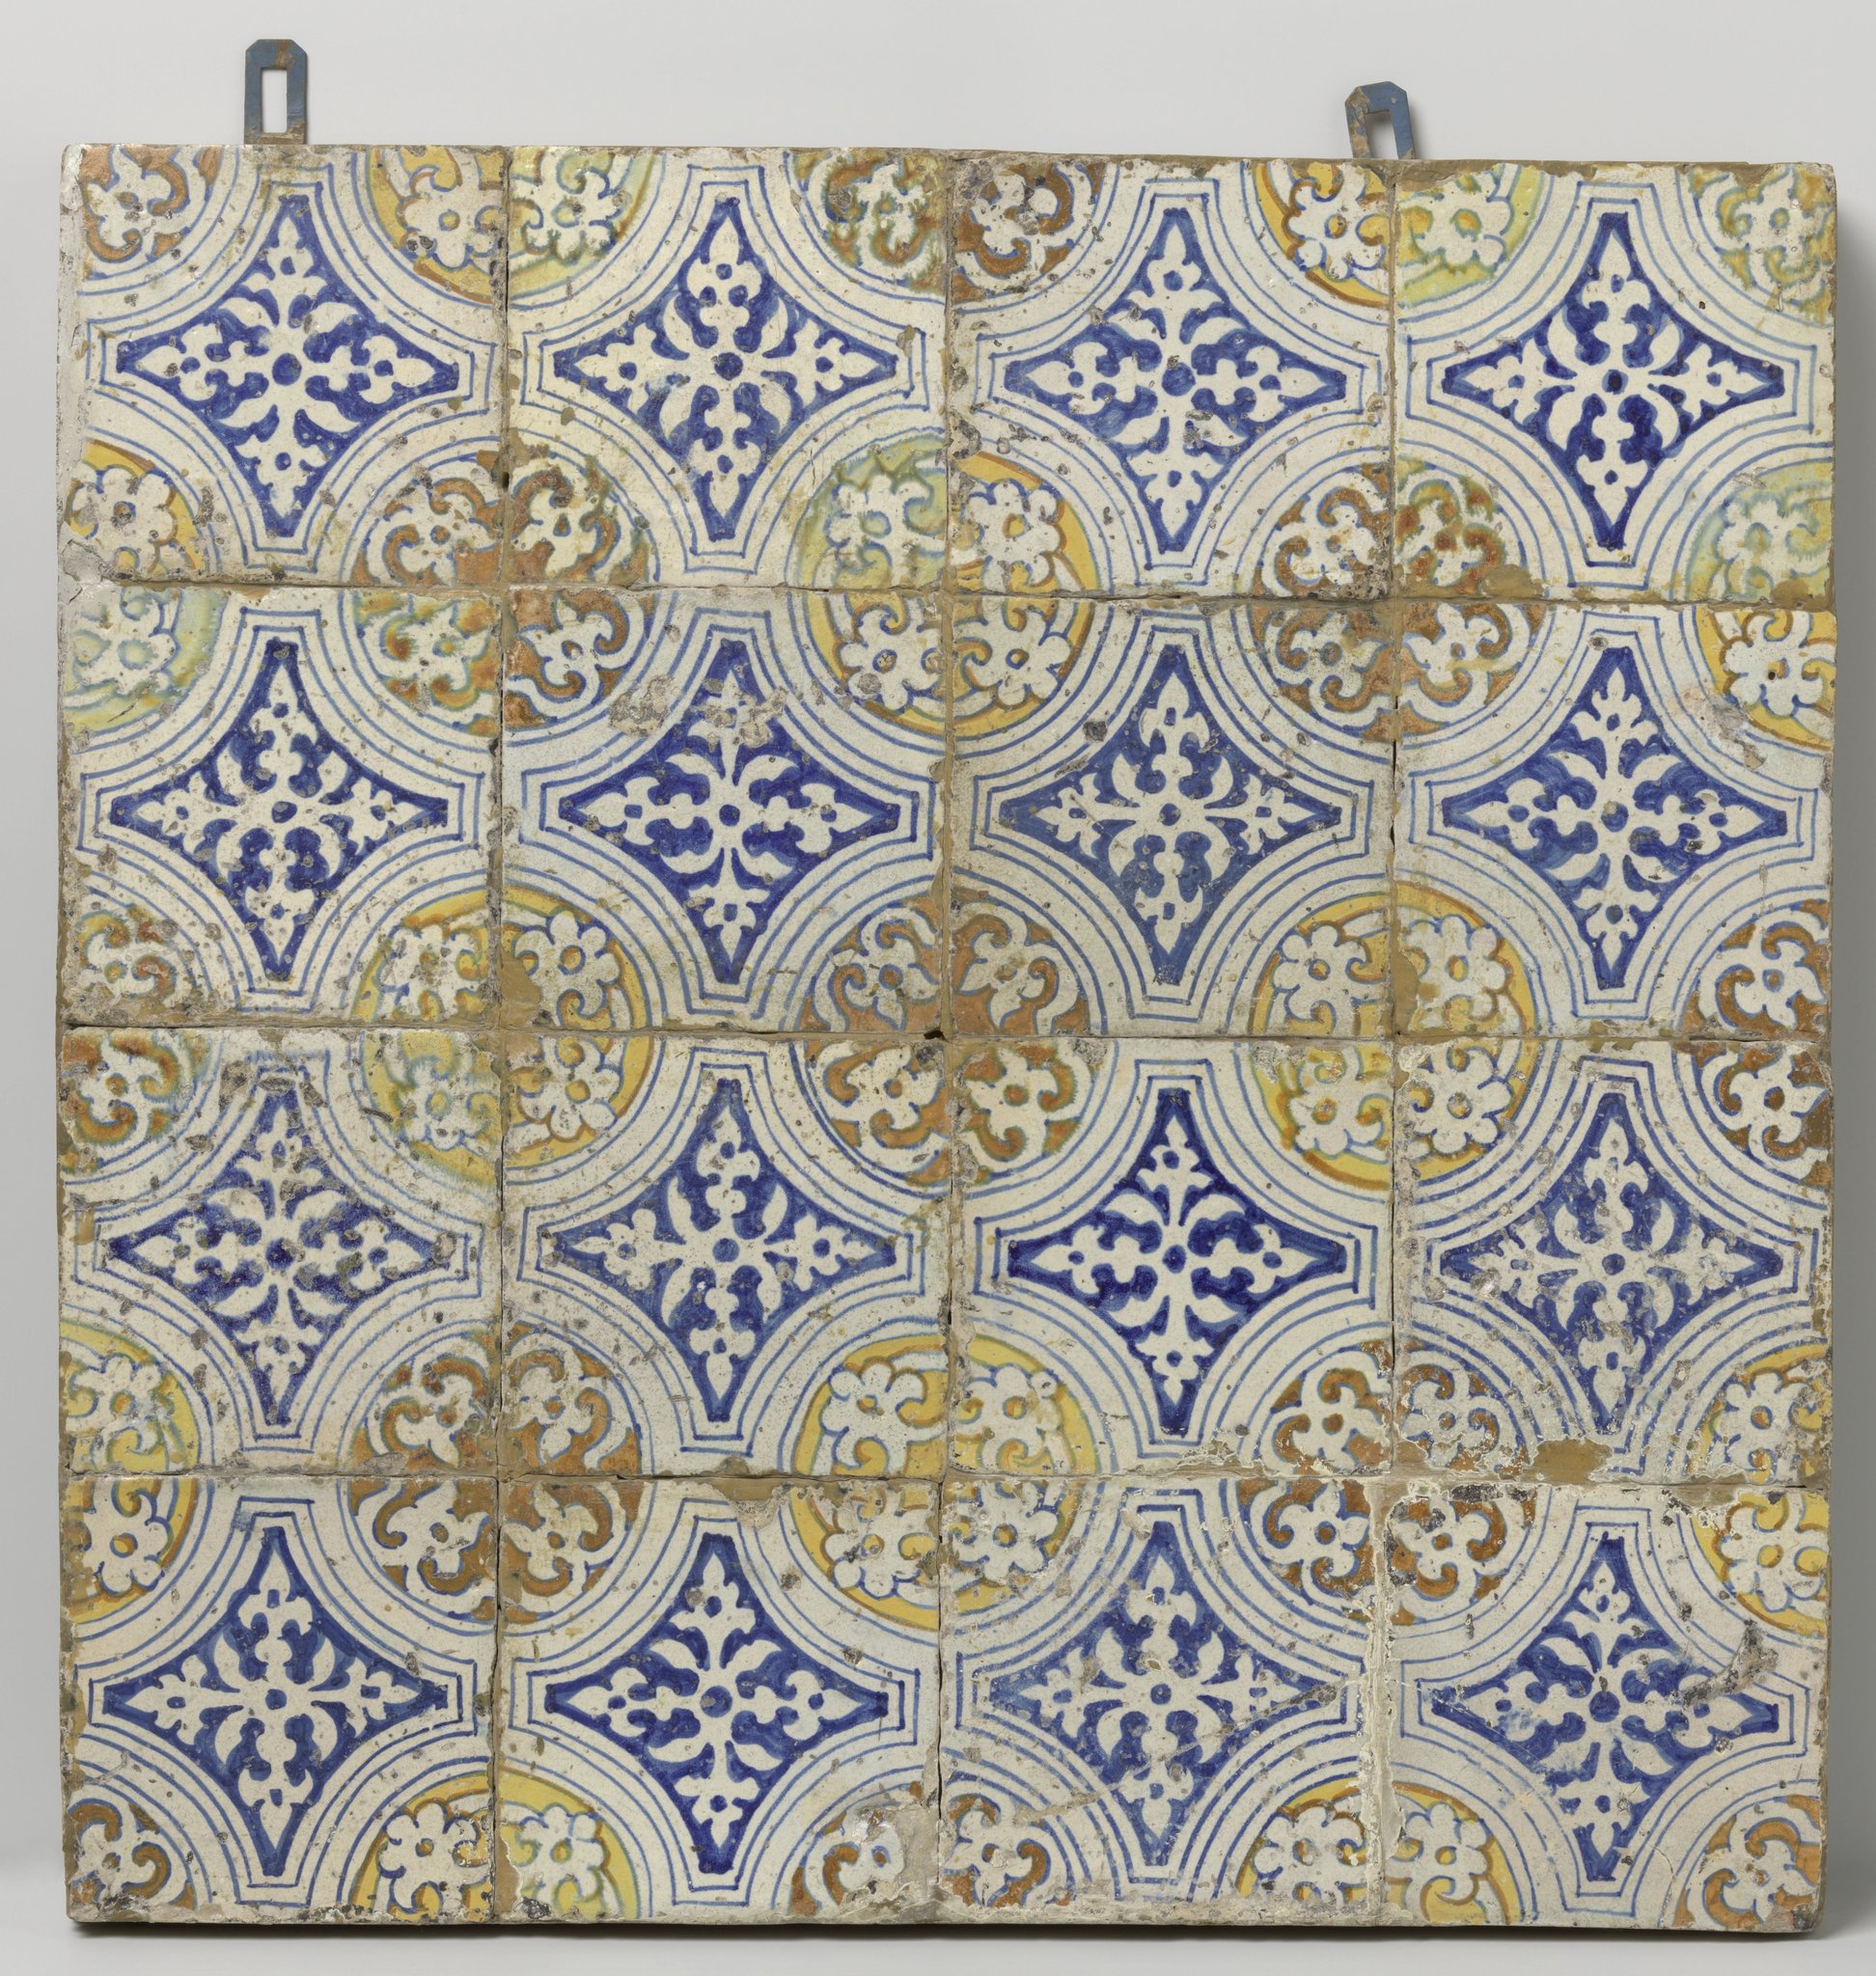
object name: tile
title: Veld van zestien tegels met bladpatroon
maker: Anonymous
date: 1560-1600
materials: earthenware, glaze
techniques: maiolica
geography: netherlands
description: Veld van zestien tegels (4 x 4) elk met een veelkleurig (blauw, geel en oranjebruin) bladpatroon in vultechniek. De hoeken zijn versierd met een bladpatroon binnen een kwart cirkel.